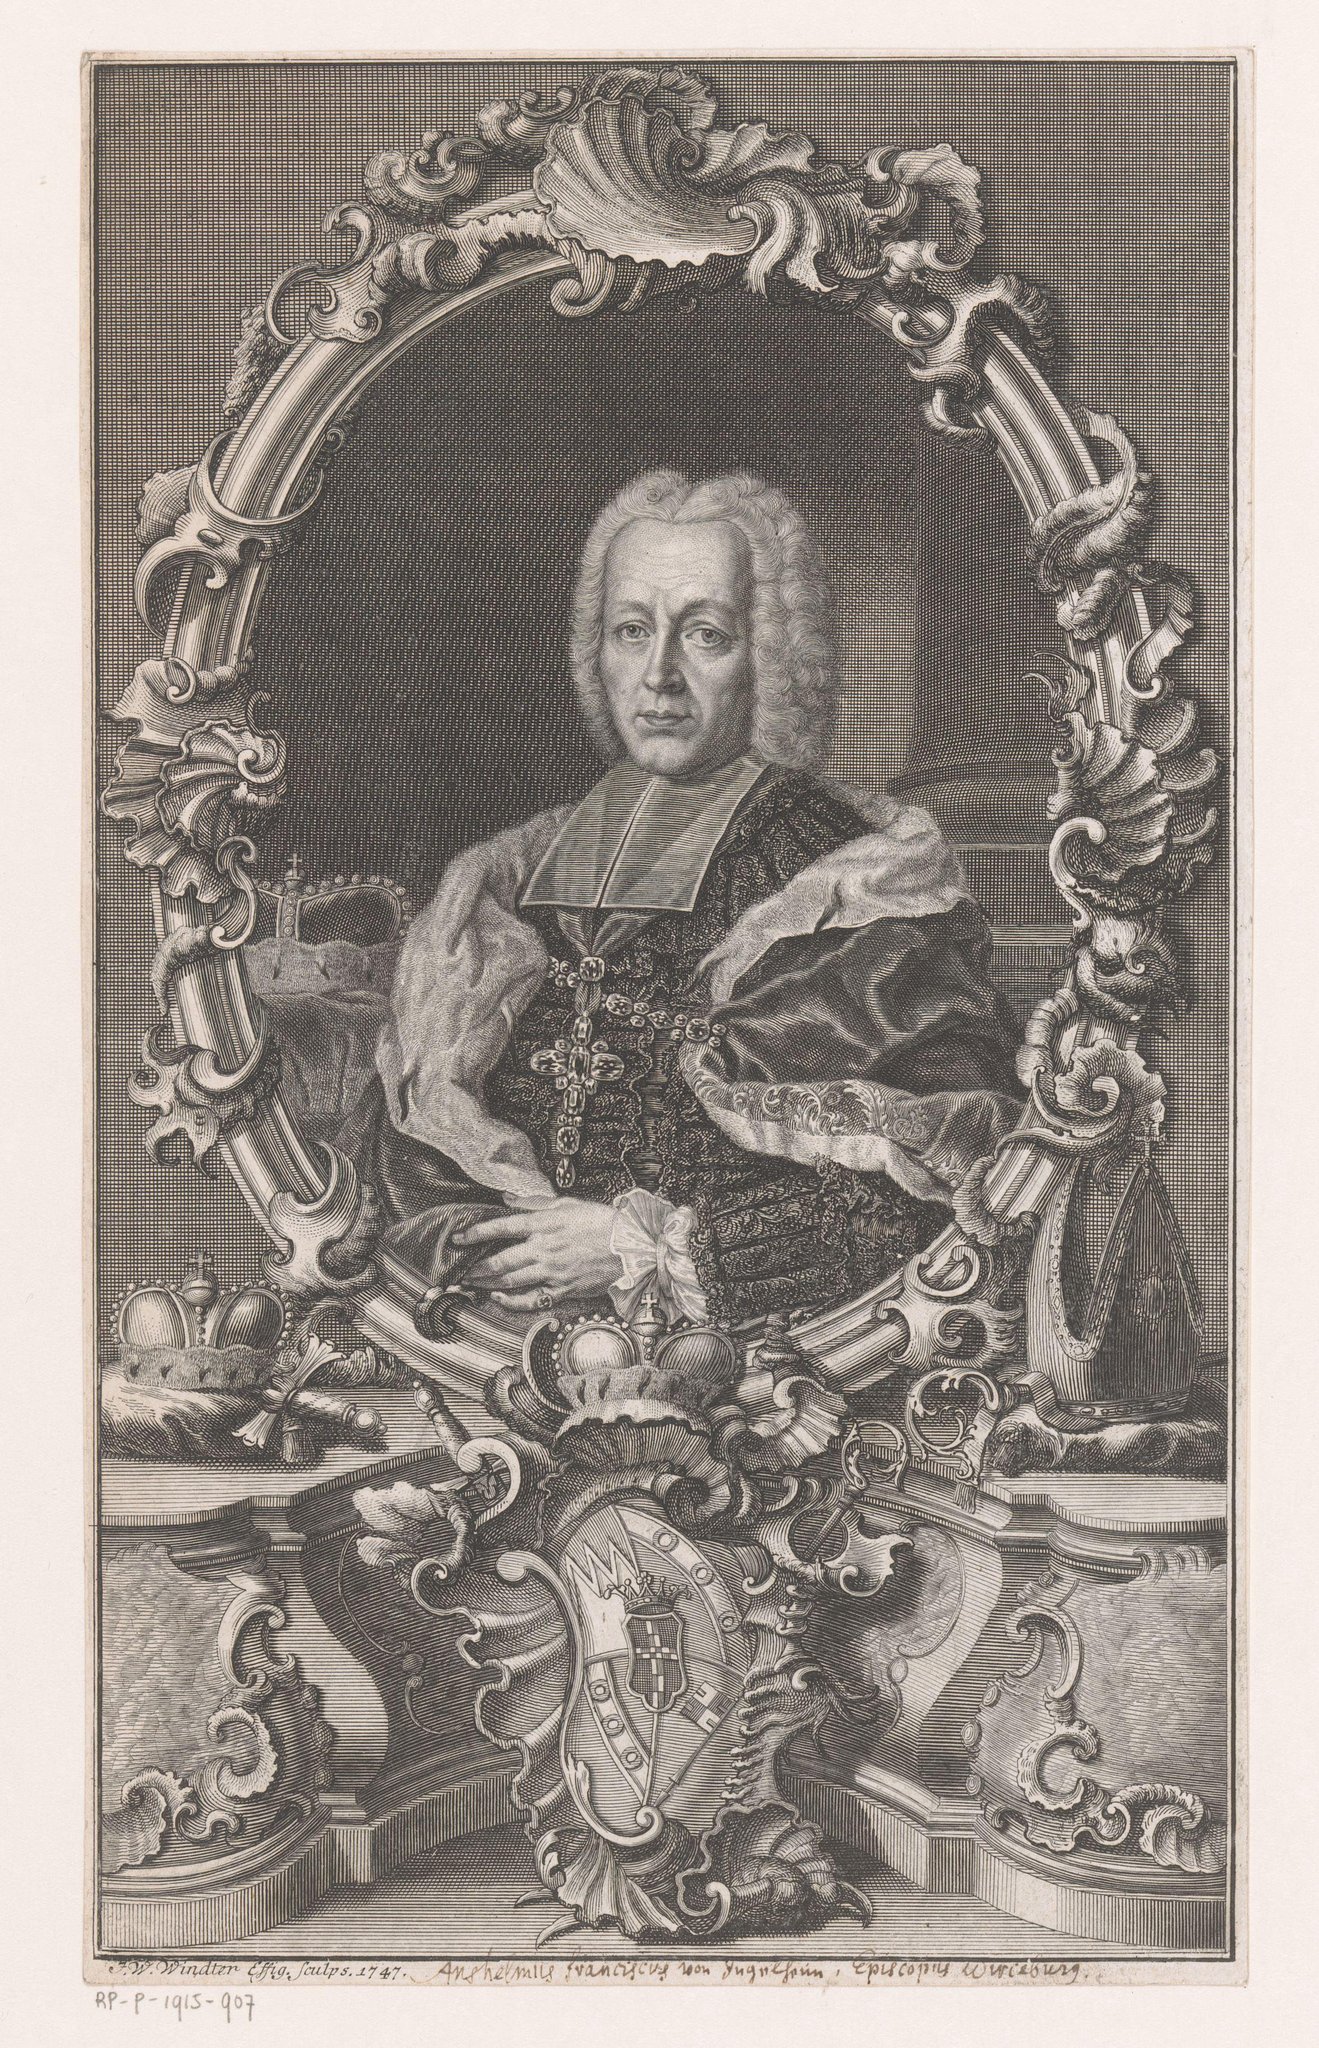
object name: print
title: Portret van Anselm Franz von Ingelheim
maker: johann wilhelm windter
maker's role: draughtsman, print maker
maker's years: 1696-1765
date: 1747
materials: paper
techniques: engraving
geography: germany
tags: historical persons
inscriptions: inscription: ‘Anshelmus franciscus von Ingelheim Episcopus Wurzburg’, collector's mark: Lugt 2228